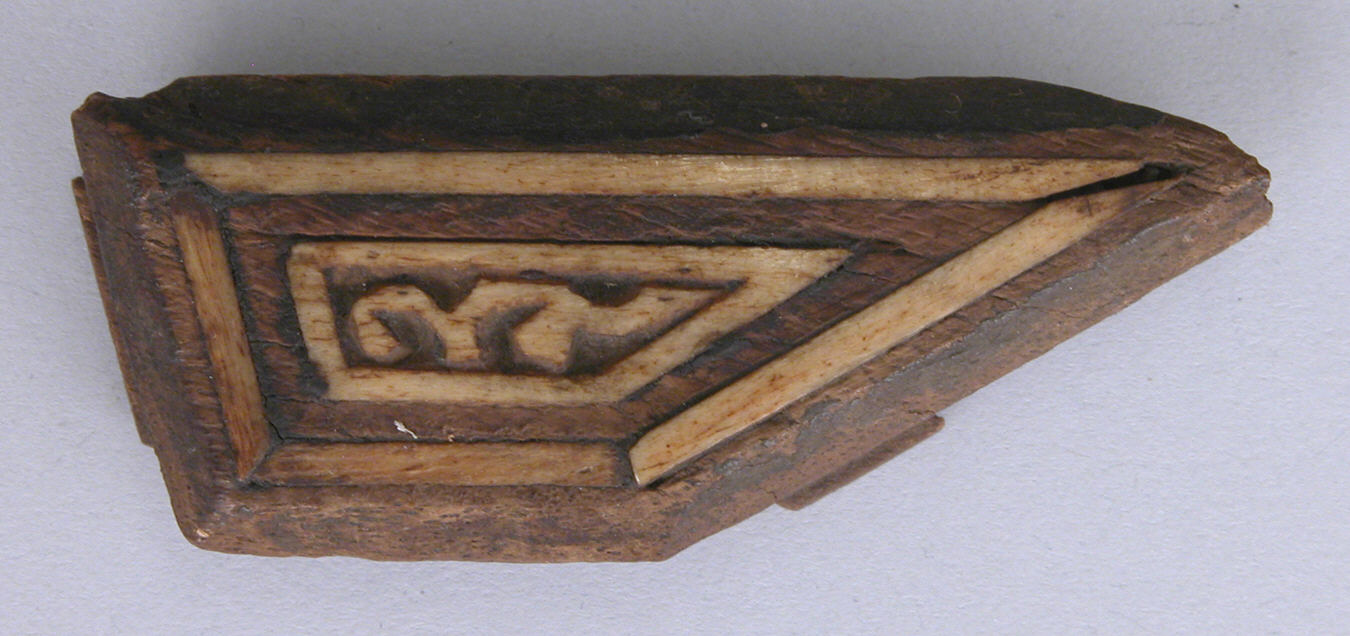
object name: panel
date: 1301-1500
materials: ivory, wood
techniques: carving, inlay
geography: egypt